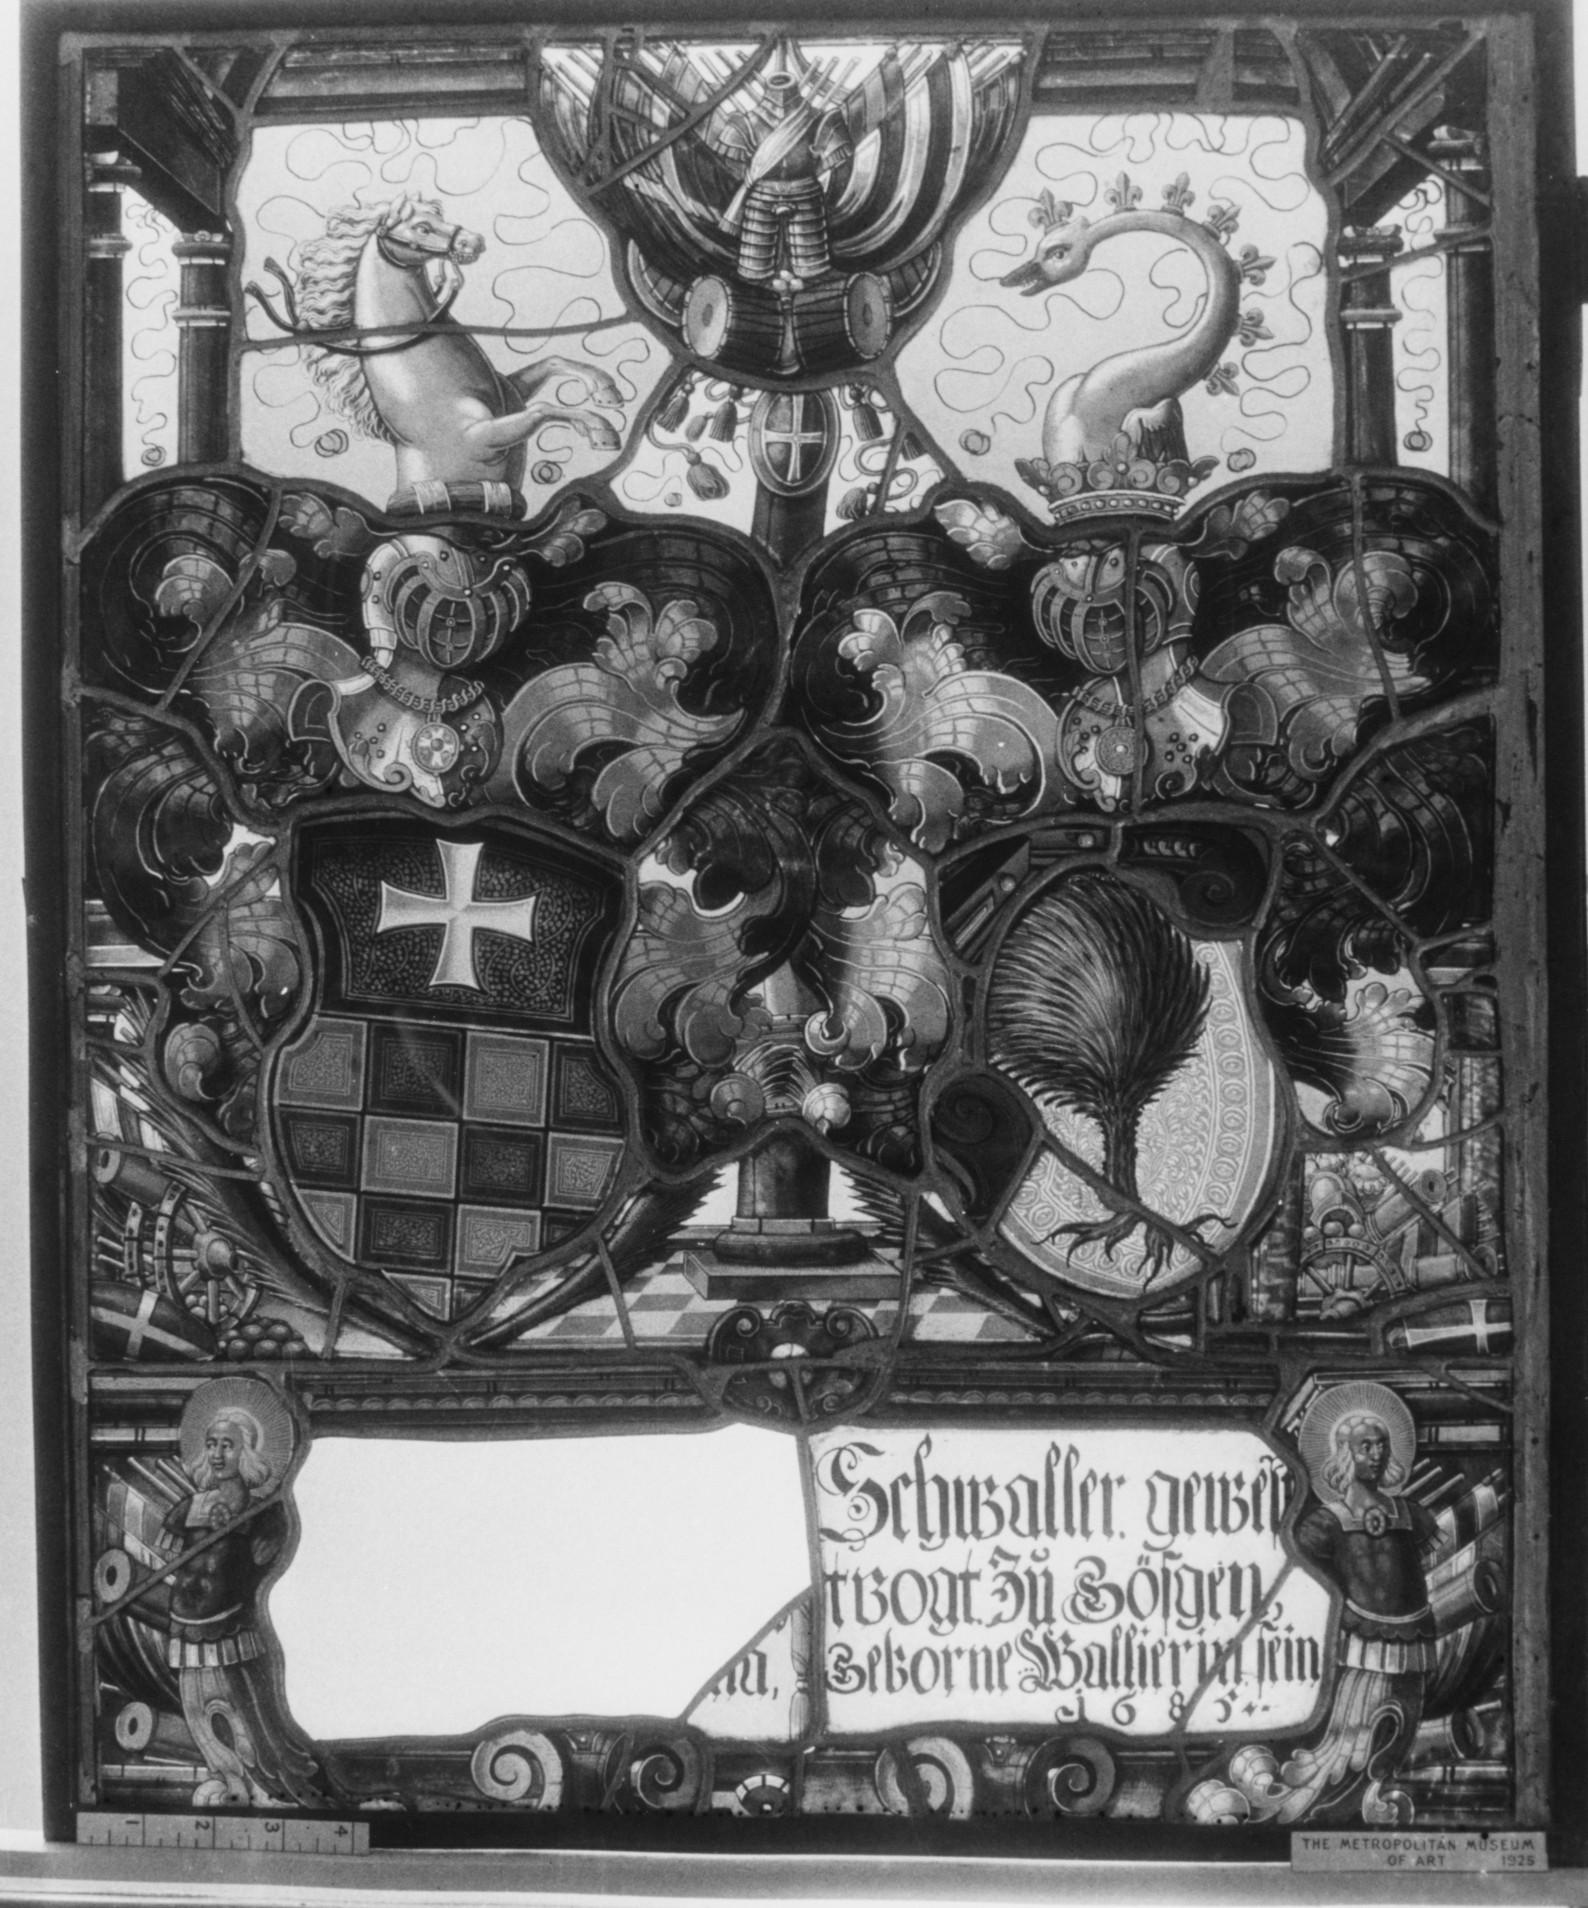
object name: armorial panel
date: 1685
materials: glass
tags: human figures,horses,coat of arms